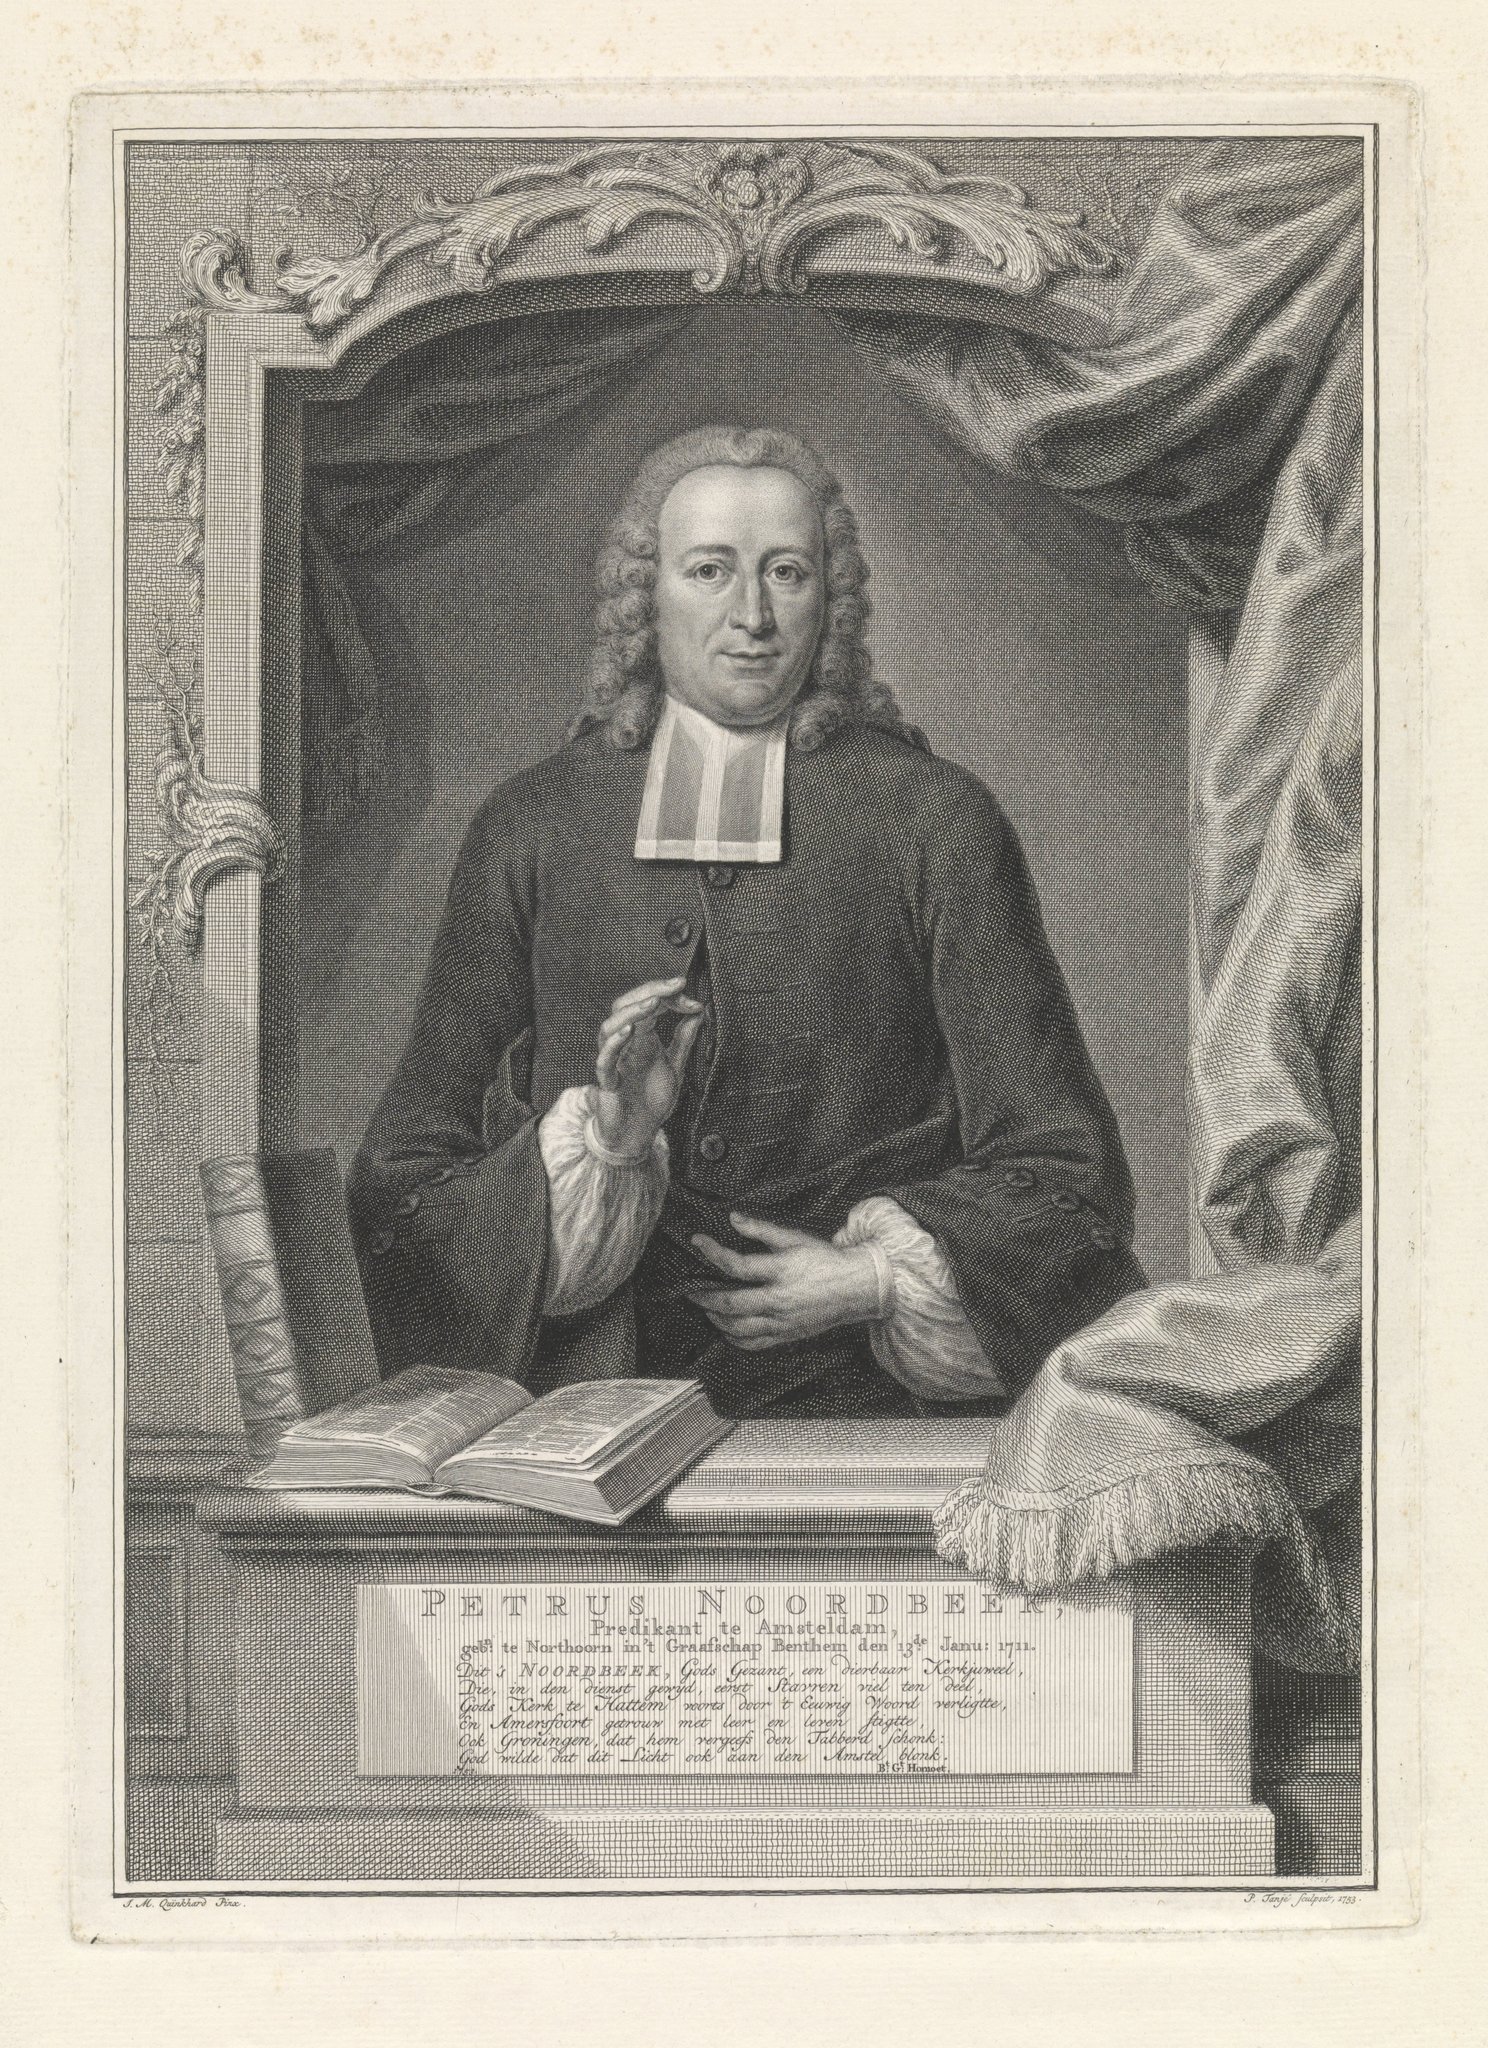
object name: print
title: Portret van Petrus Noordbeek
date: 1753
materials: paper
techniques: engraving, etching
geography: amsterdam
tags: the bible as a book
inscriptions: collector's mark: Lugt 2228, collector's mark: Lugt 240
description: Portret van Petrus Noordbeek, predikant te Amsterdam, staande bij een opengeslagen bijbel.